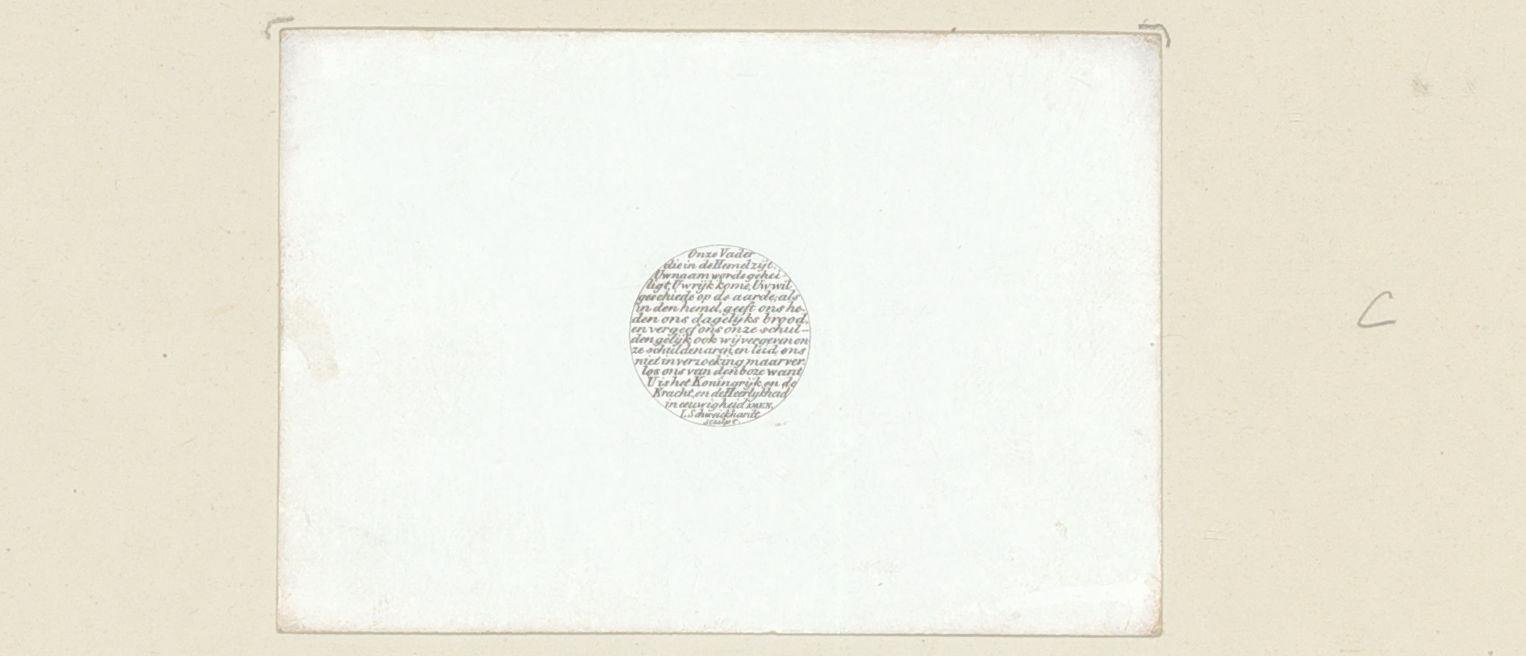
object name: print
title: Adreskaart van Leonardus Schweickhardt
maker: leonardus schweickhardt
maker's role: print maker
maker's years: 1783-1862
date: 1793-1862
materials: porcelainized cardboard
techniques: engraving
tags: the hague, print maker, leonardus schweickhardt, 'our father which art in heaven' ~ the lord's prayer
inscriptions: stamp, collector's mark: Lugt 1641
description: In een kleine cirkel (diameter ca. 15 millimeter) is het Onzevader gegraveerd, met daarbij: 'L. Schweickhardt Kunst Graveur 's Gravenhage'. Onderwerpsrubrieken binnen de Atlas Zeden en Gewoonten: Godsdienst, Roomsch-Katholieken, Processies, Herinneringen.